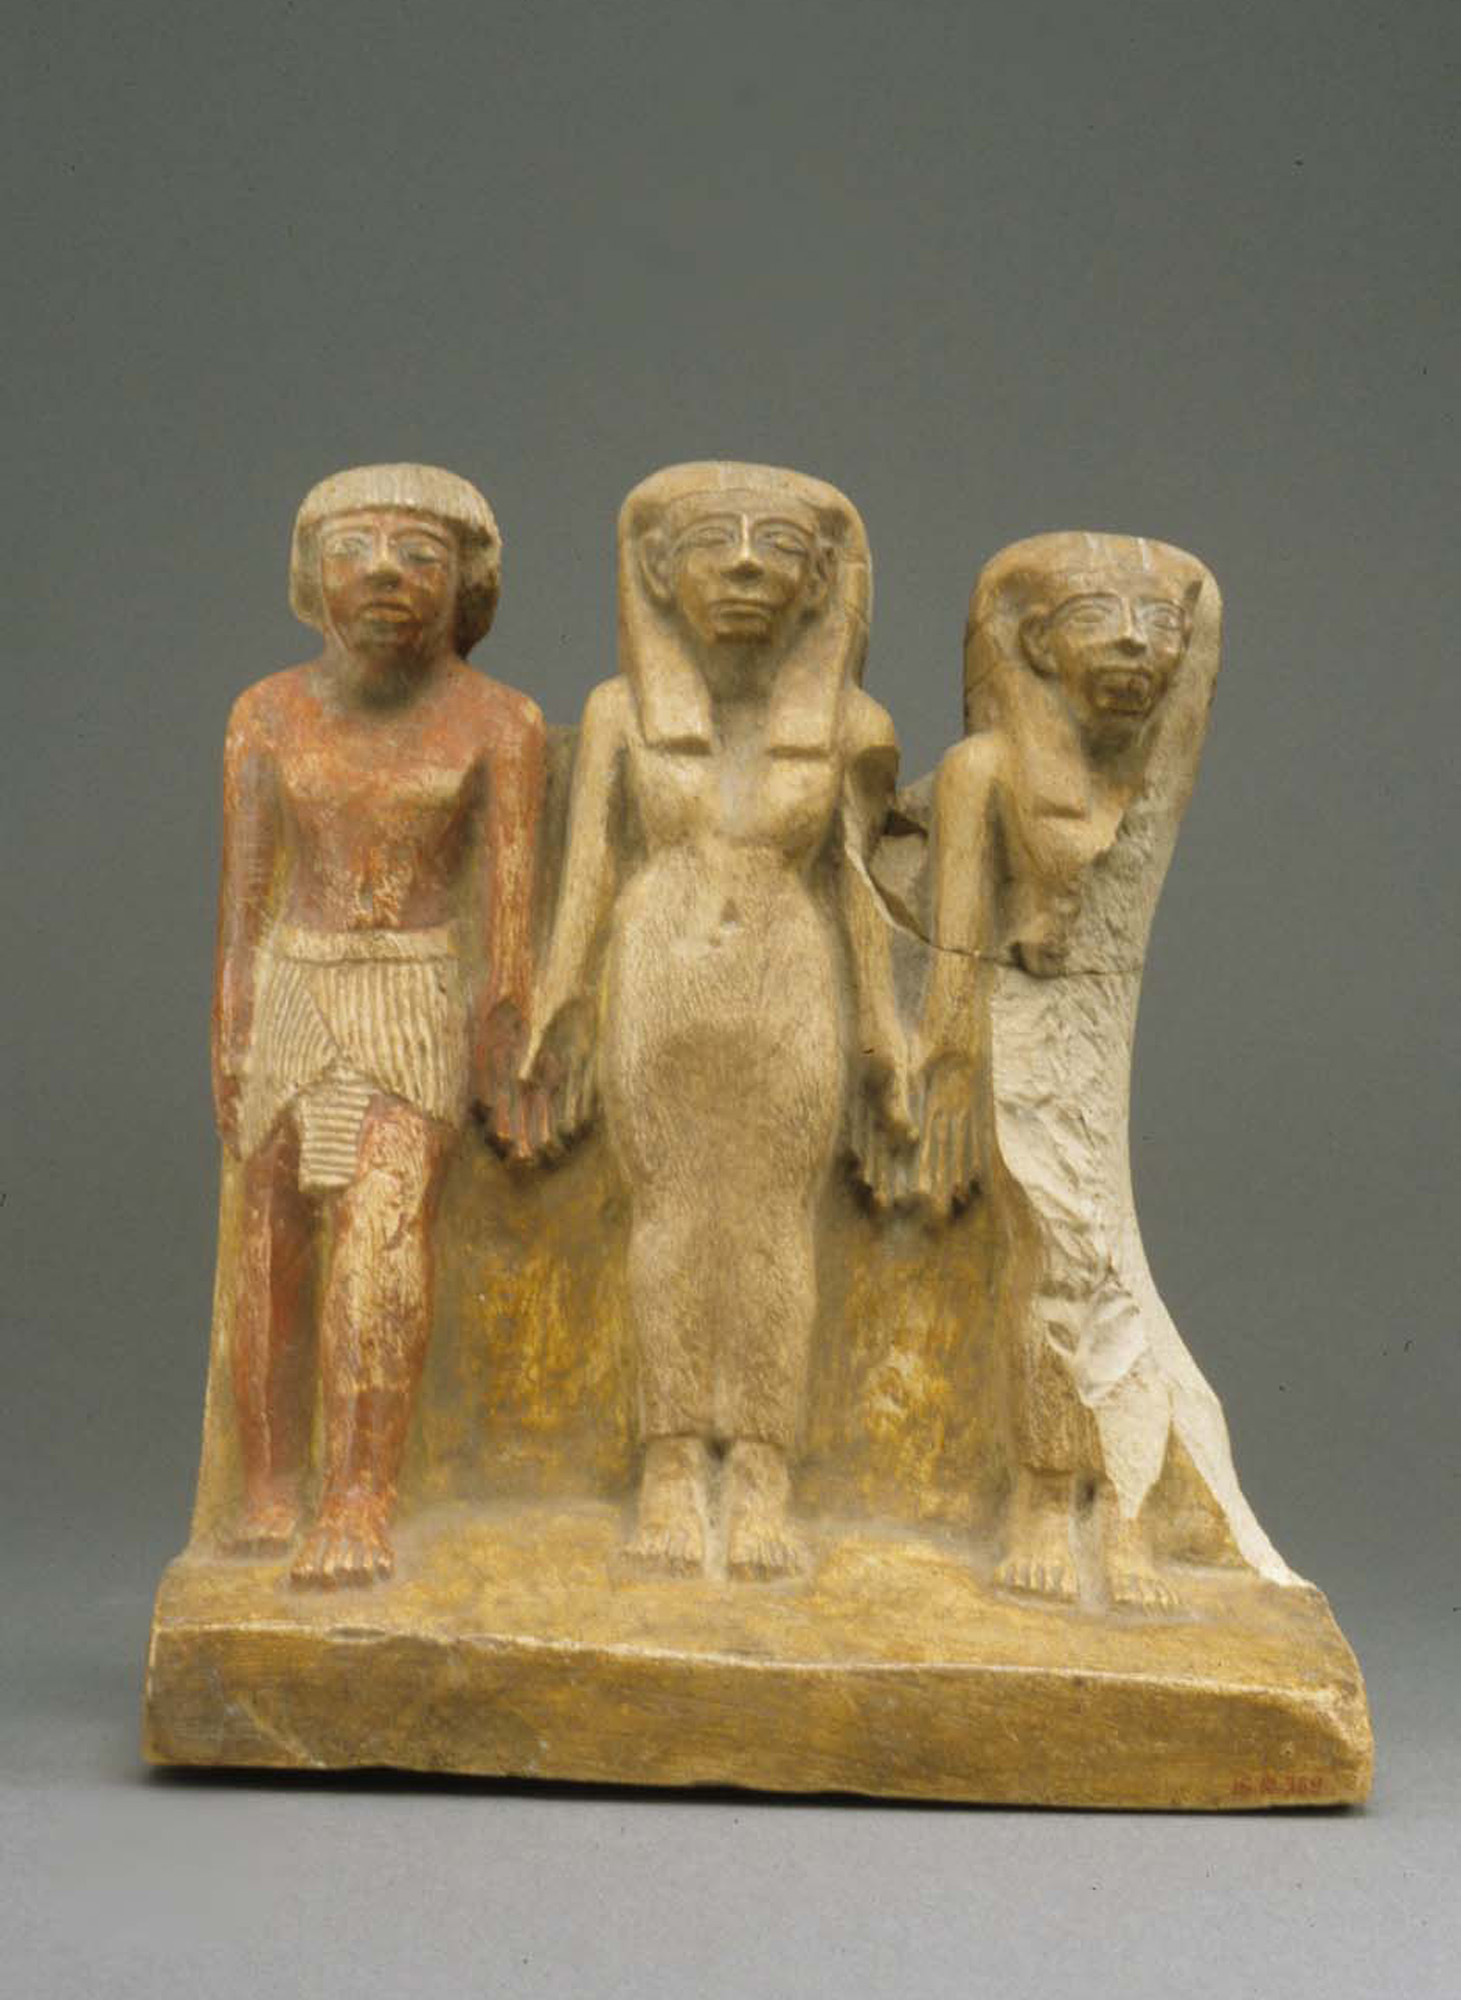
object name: statuette group, standing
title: Triad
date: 1635-1458 BCE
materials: limestone, paint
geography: egypt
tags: men